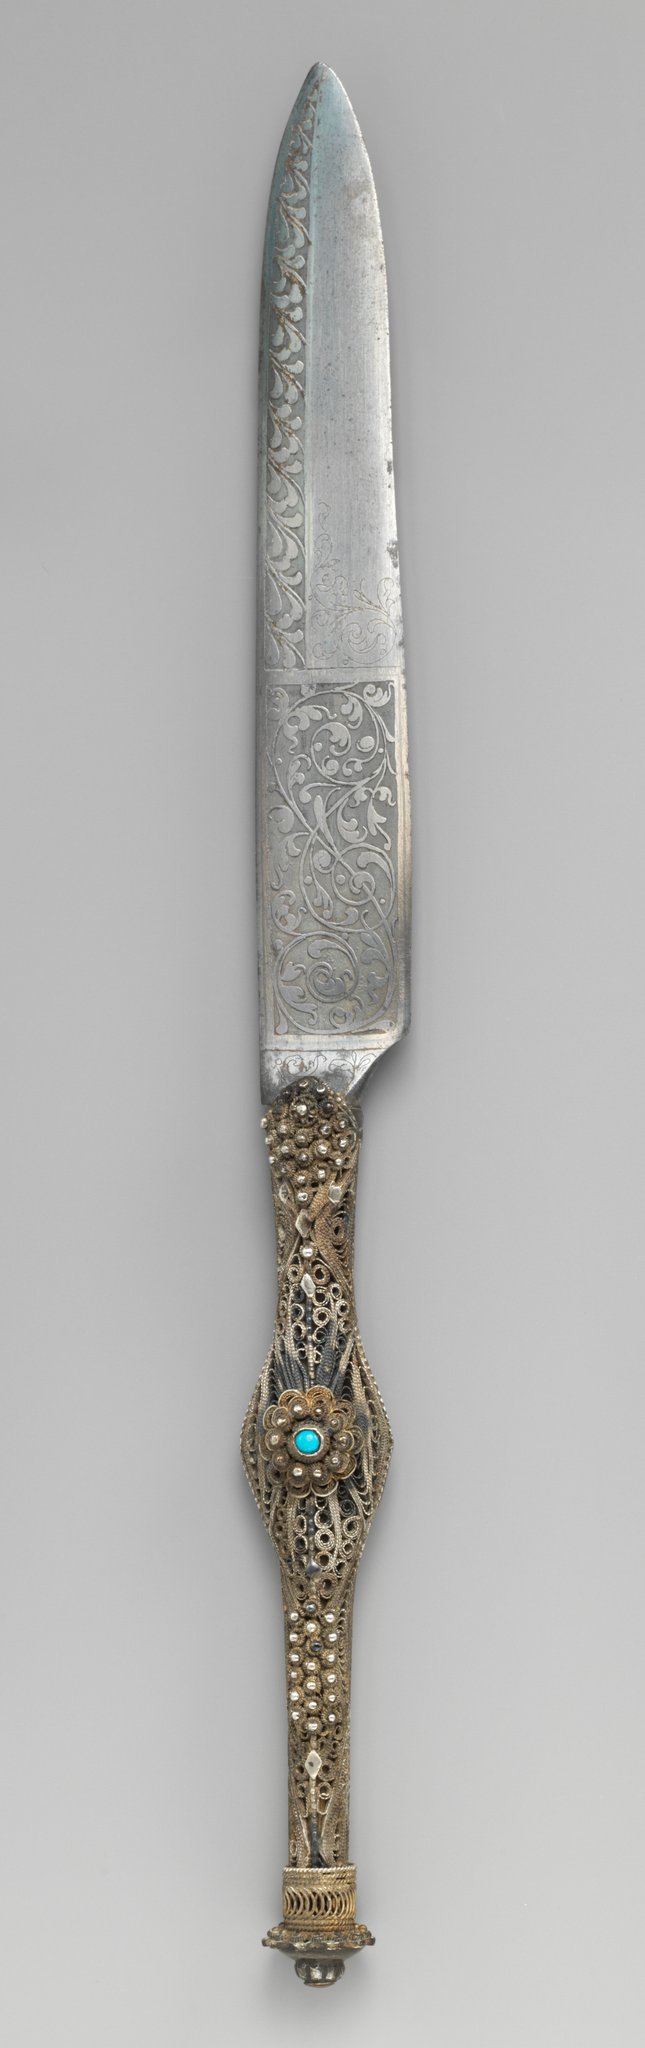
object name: knife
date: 1801-1900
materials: glass, silver, steel